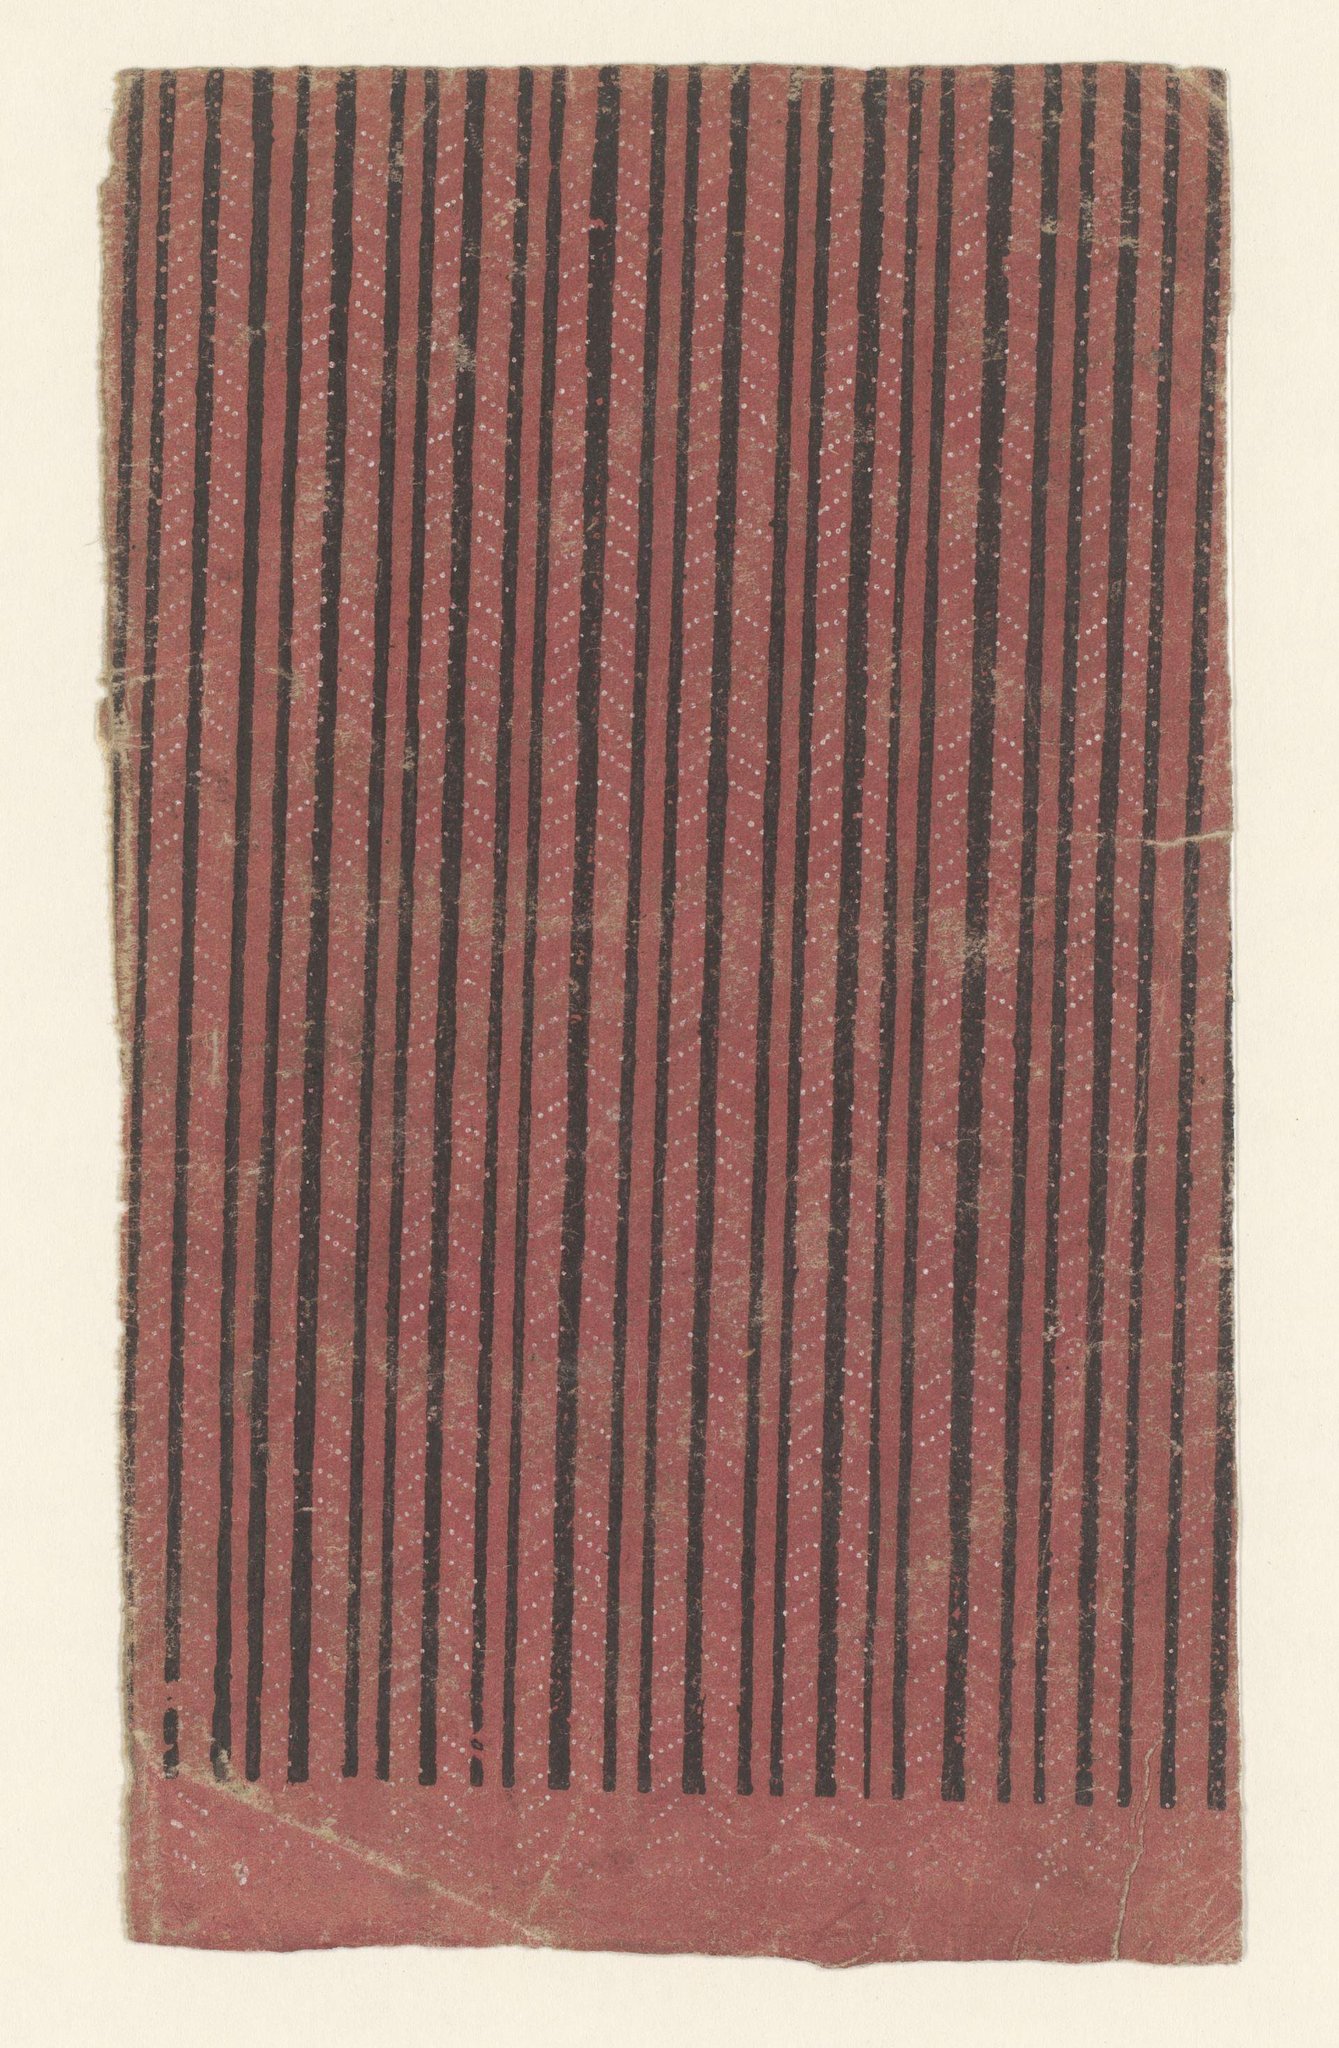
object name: printed paper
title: Blad met verticaal banenpatroon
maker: Anonymous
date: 1700-1850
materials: paper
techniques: printing block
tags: ornament ~ geometric motifs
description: Blad met verticaal banenpatroon van lijnen en stippen. Helft van een omslag.